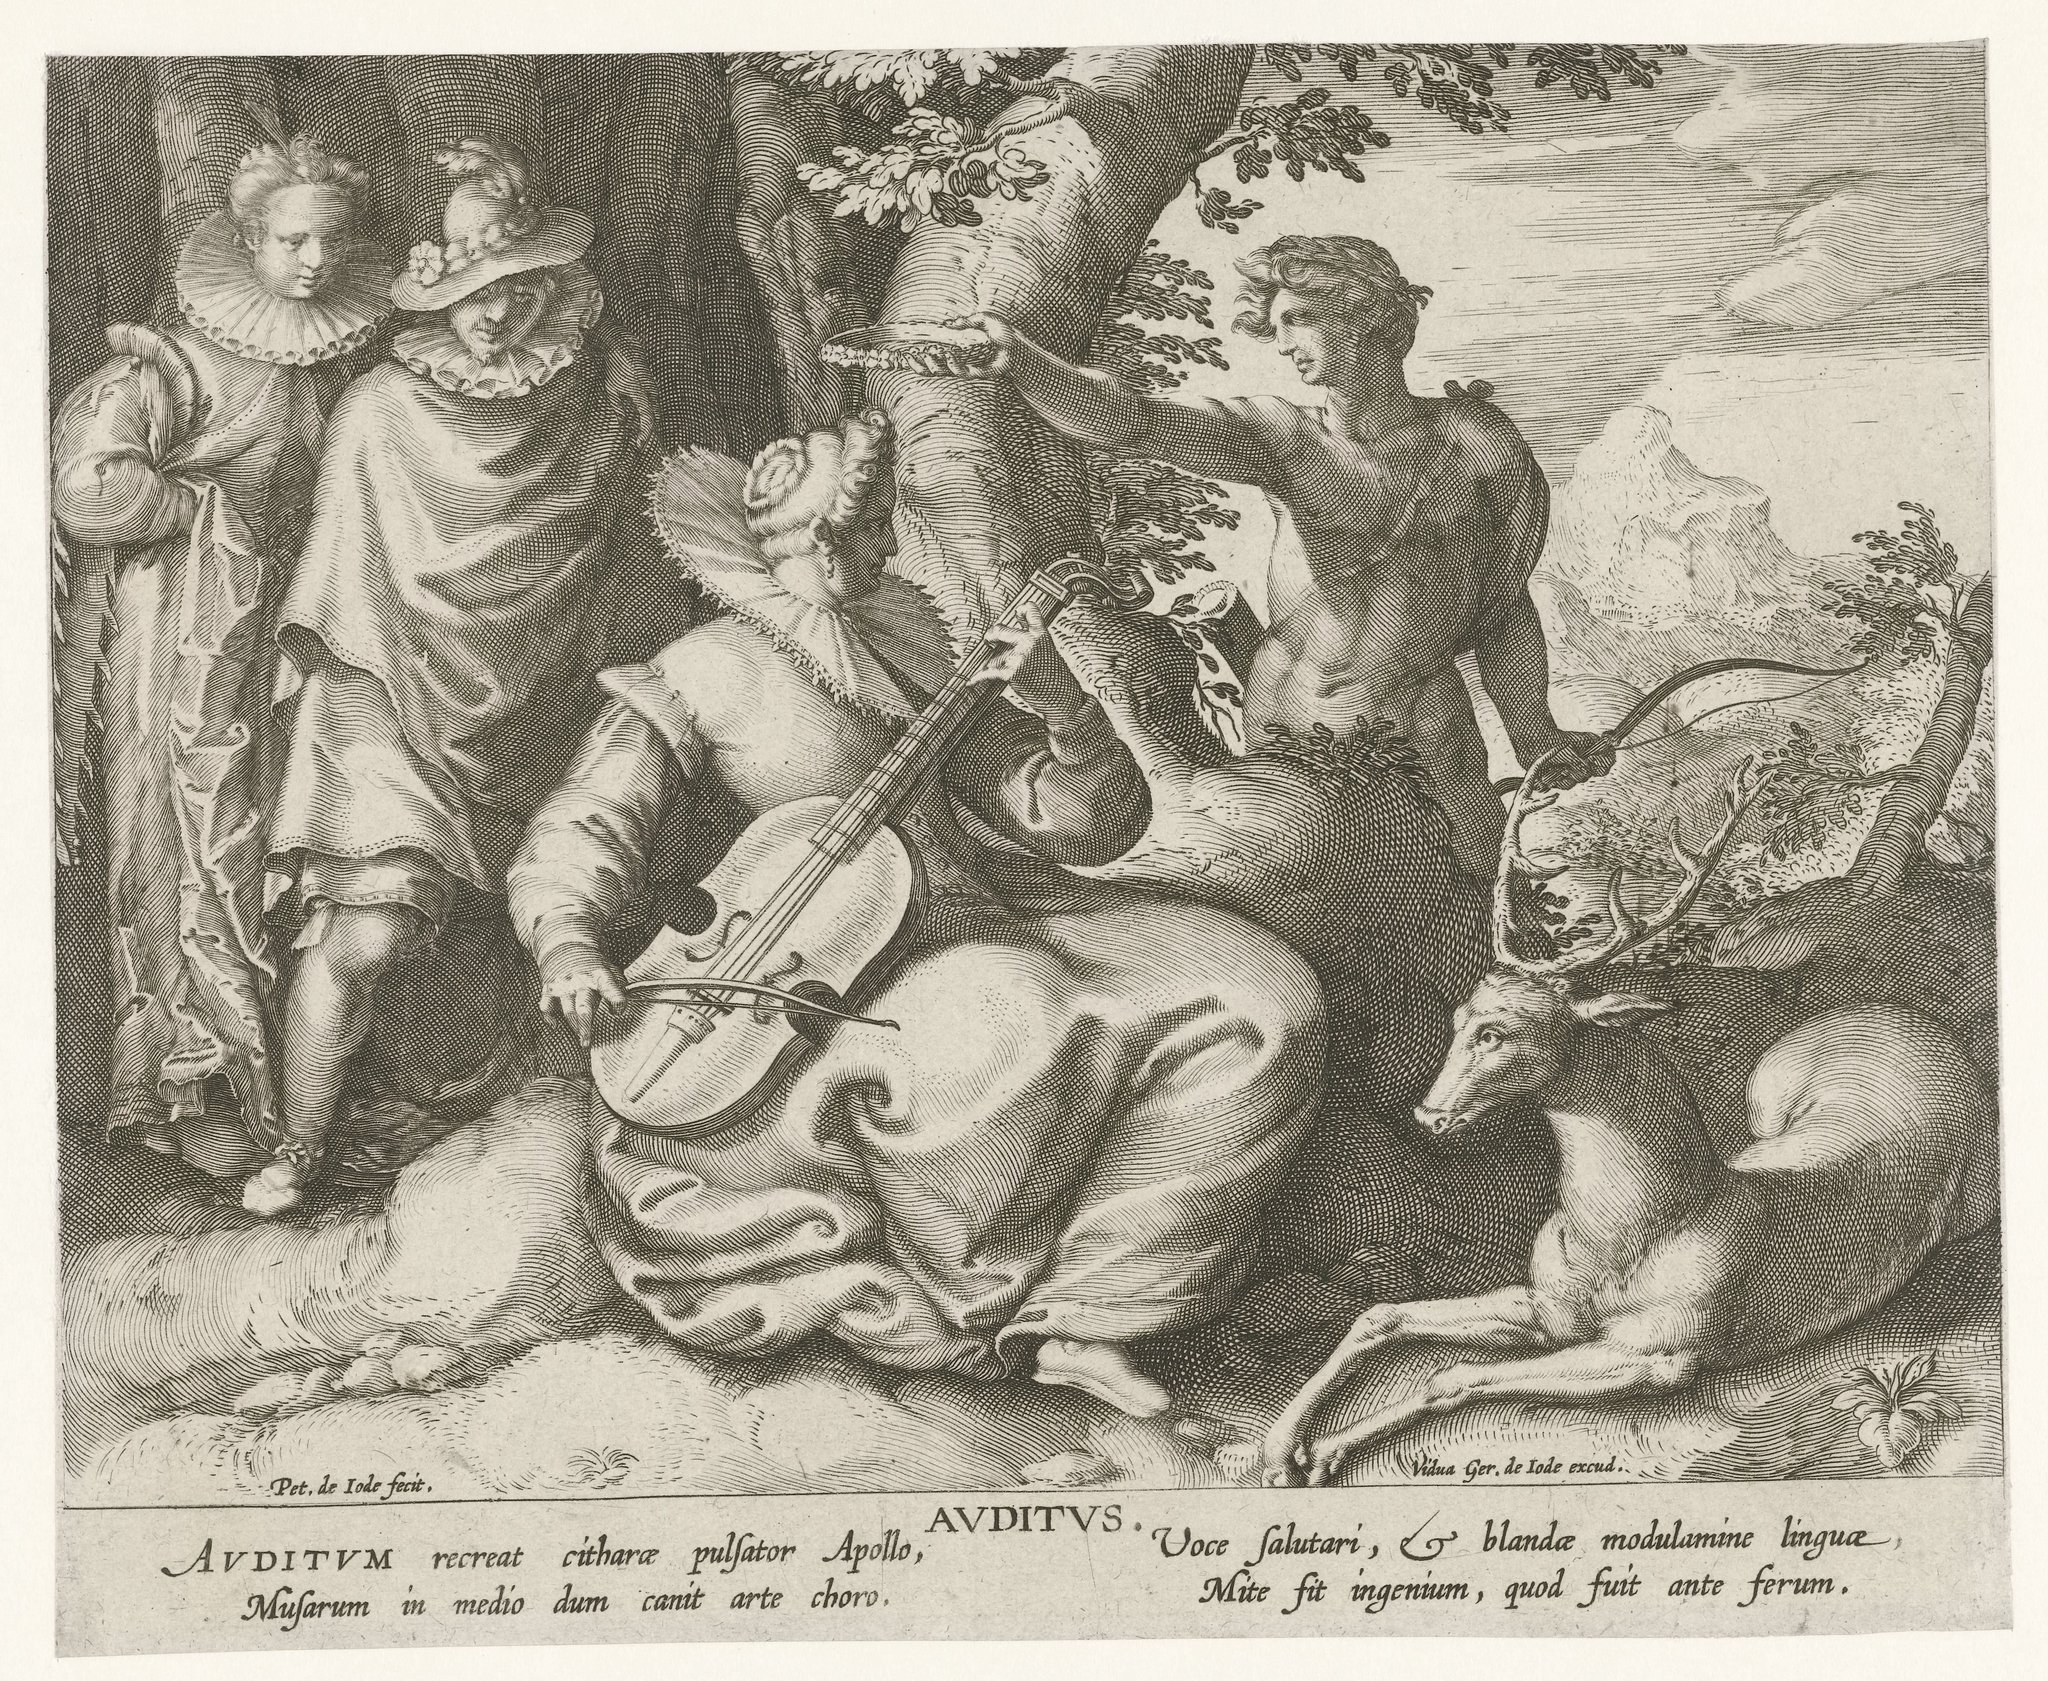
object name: print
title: De vijf zintuigen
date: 1590-1632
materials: paper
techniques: engraving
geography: antwerp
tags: hearing, listening (one of the five senses), (story of) apollo (phoebus)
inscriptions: collector's mark: Lugt 2228, collector's mark: Lugt 2760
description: Landschap met de vrouwelijke personificatie van het Gehoor, die een vedel bespeelt. Ze wordt vergezeld door een hert en gekroond door Apollo. Linksachter staat een paar dat toekijkt. In de marge, in twee kolommen, een onderschrift in het Latijn. Prent uit een serie van vijf met de vijf zintuigen.